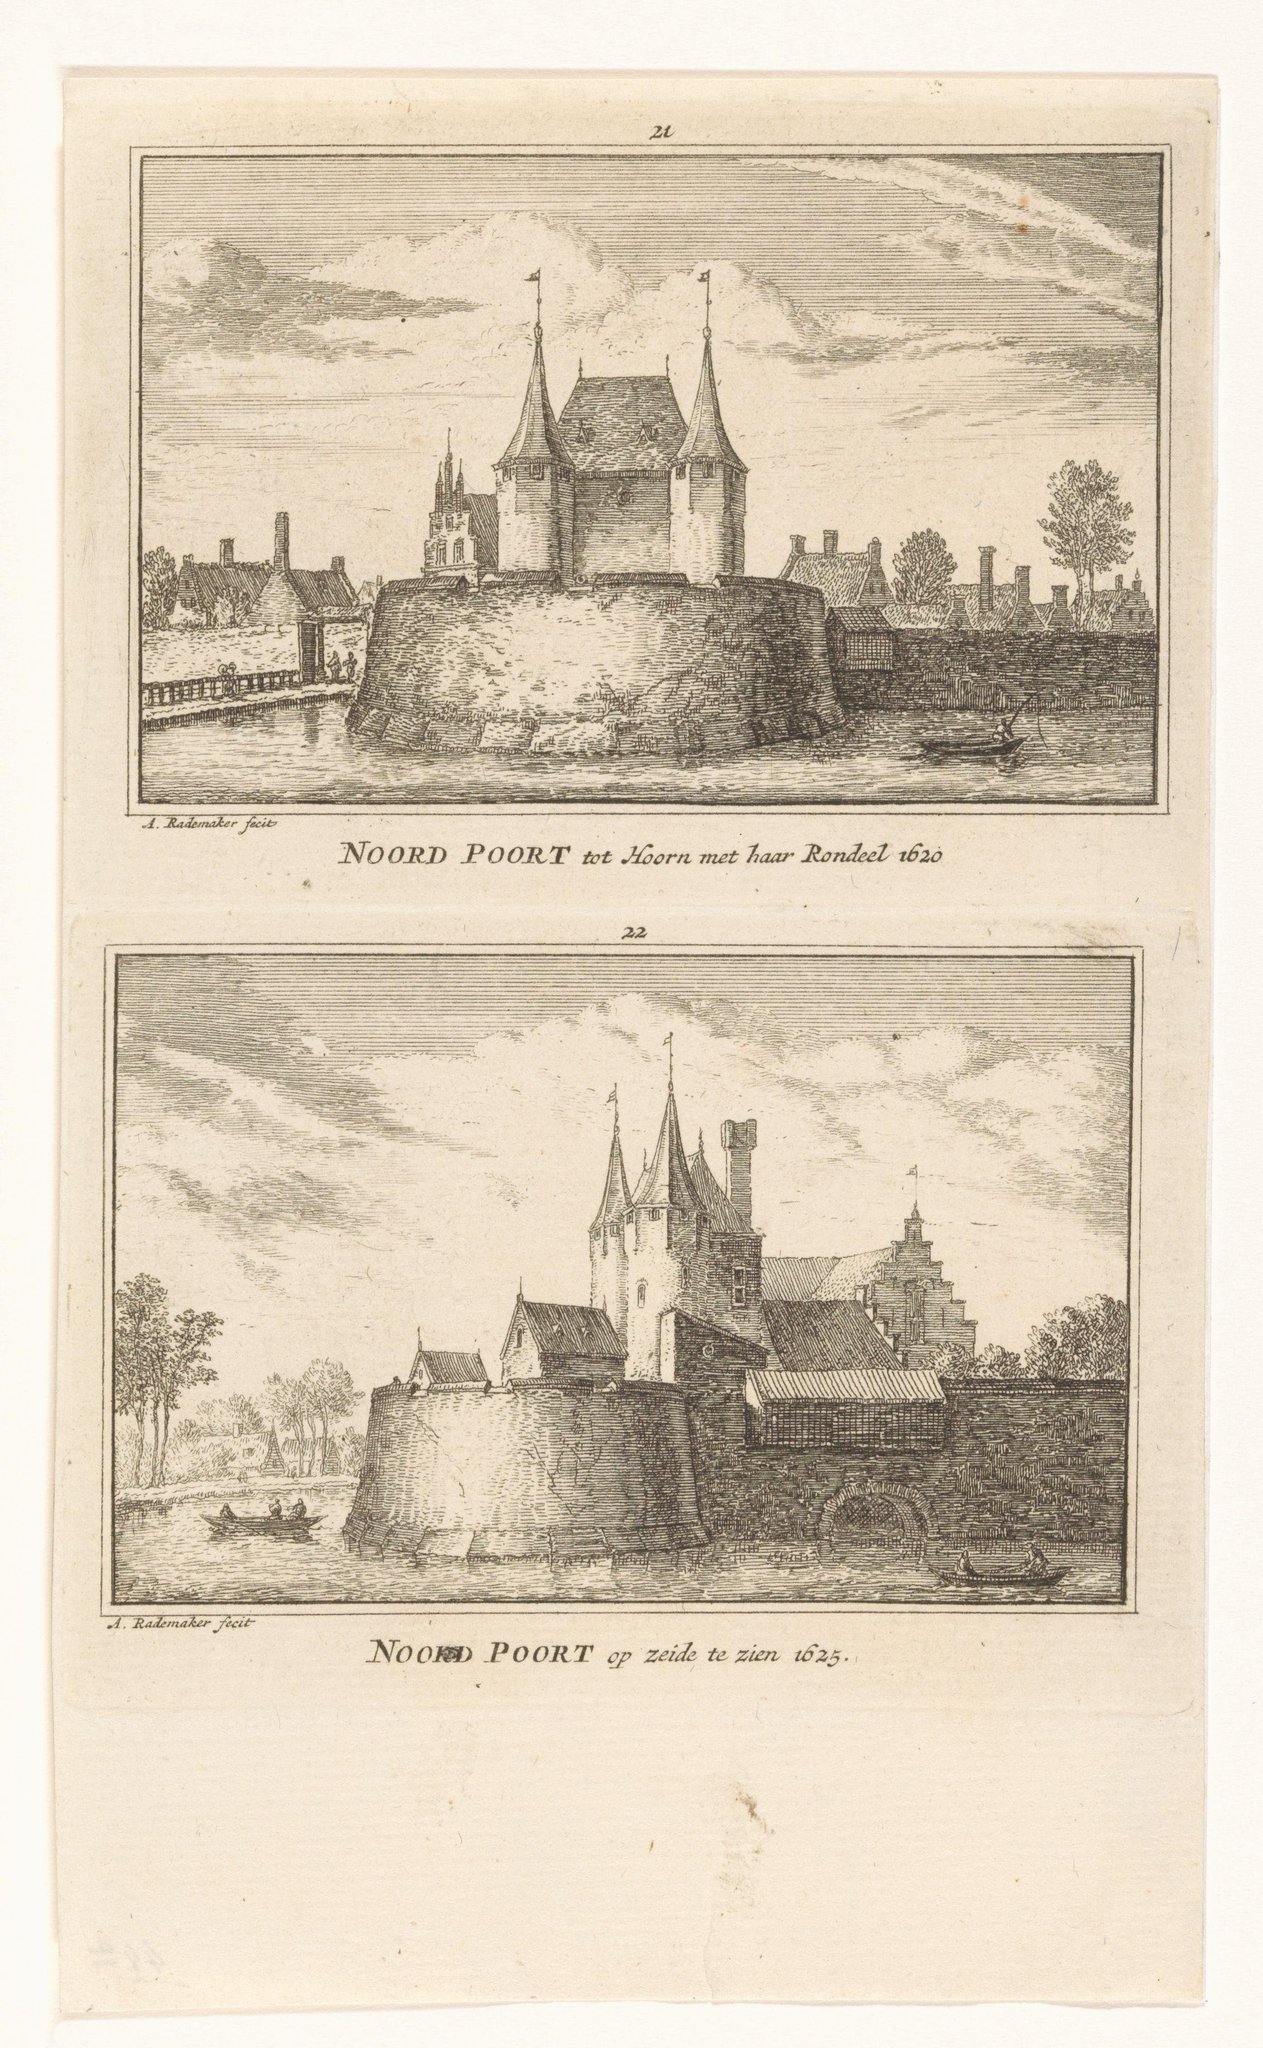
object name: print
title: Gezicht op de Westerpoort te Hoorn, 1726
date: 1757-1792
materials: paper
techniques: engraving, etching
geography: haarlem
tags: bridge, city-gate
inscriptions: collector's mark: Lugt 195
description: Prent ook gebruikt in: Het verheerlykt Nederland of kabinet van hedendaagsche gezigten van steden, dorpen (…). 9 delen. Amsterdam: Isaak Tirion en weduwe Isaak Tirion, 1745-1774, dl. 6 (1757), ill. 402. Of in: Nederlandsche tafereelen; of eene keurige verzameling van negen honderd fraaije gezigten van steden, dorpen, sloten, oudheden (….). 9 delen. Amsterdam: Jan de Groot, 1792, dl. 6, ill. 402. Uit welke druk het huidige exemplaar precies komt is niet na te gaan.